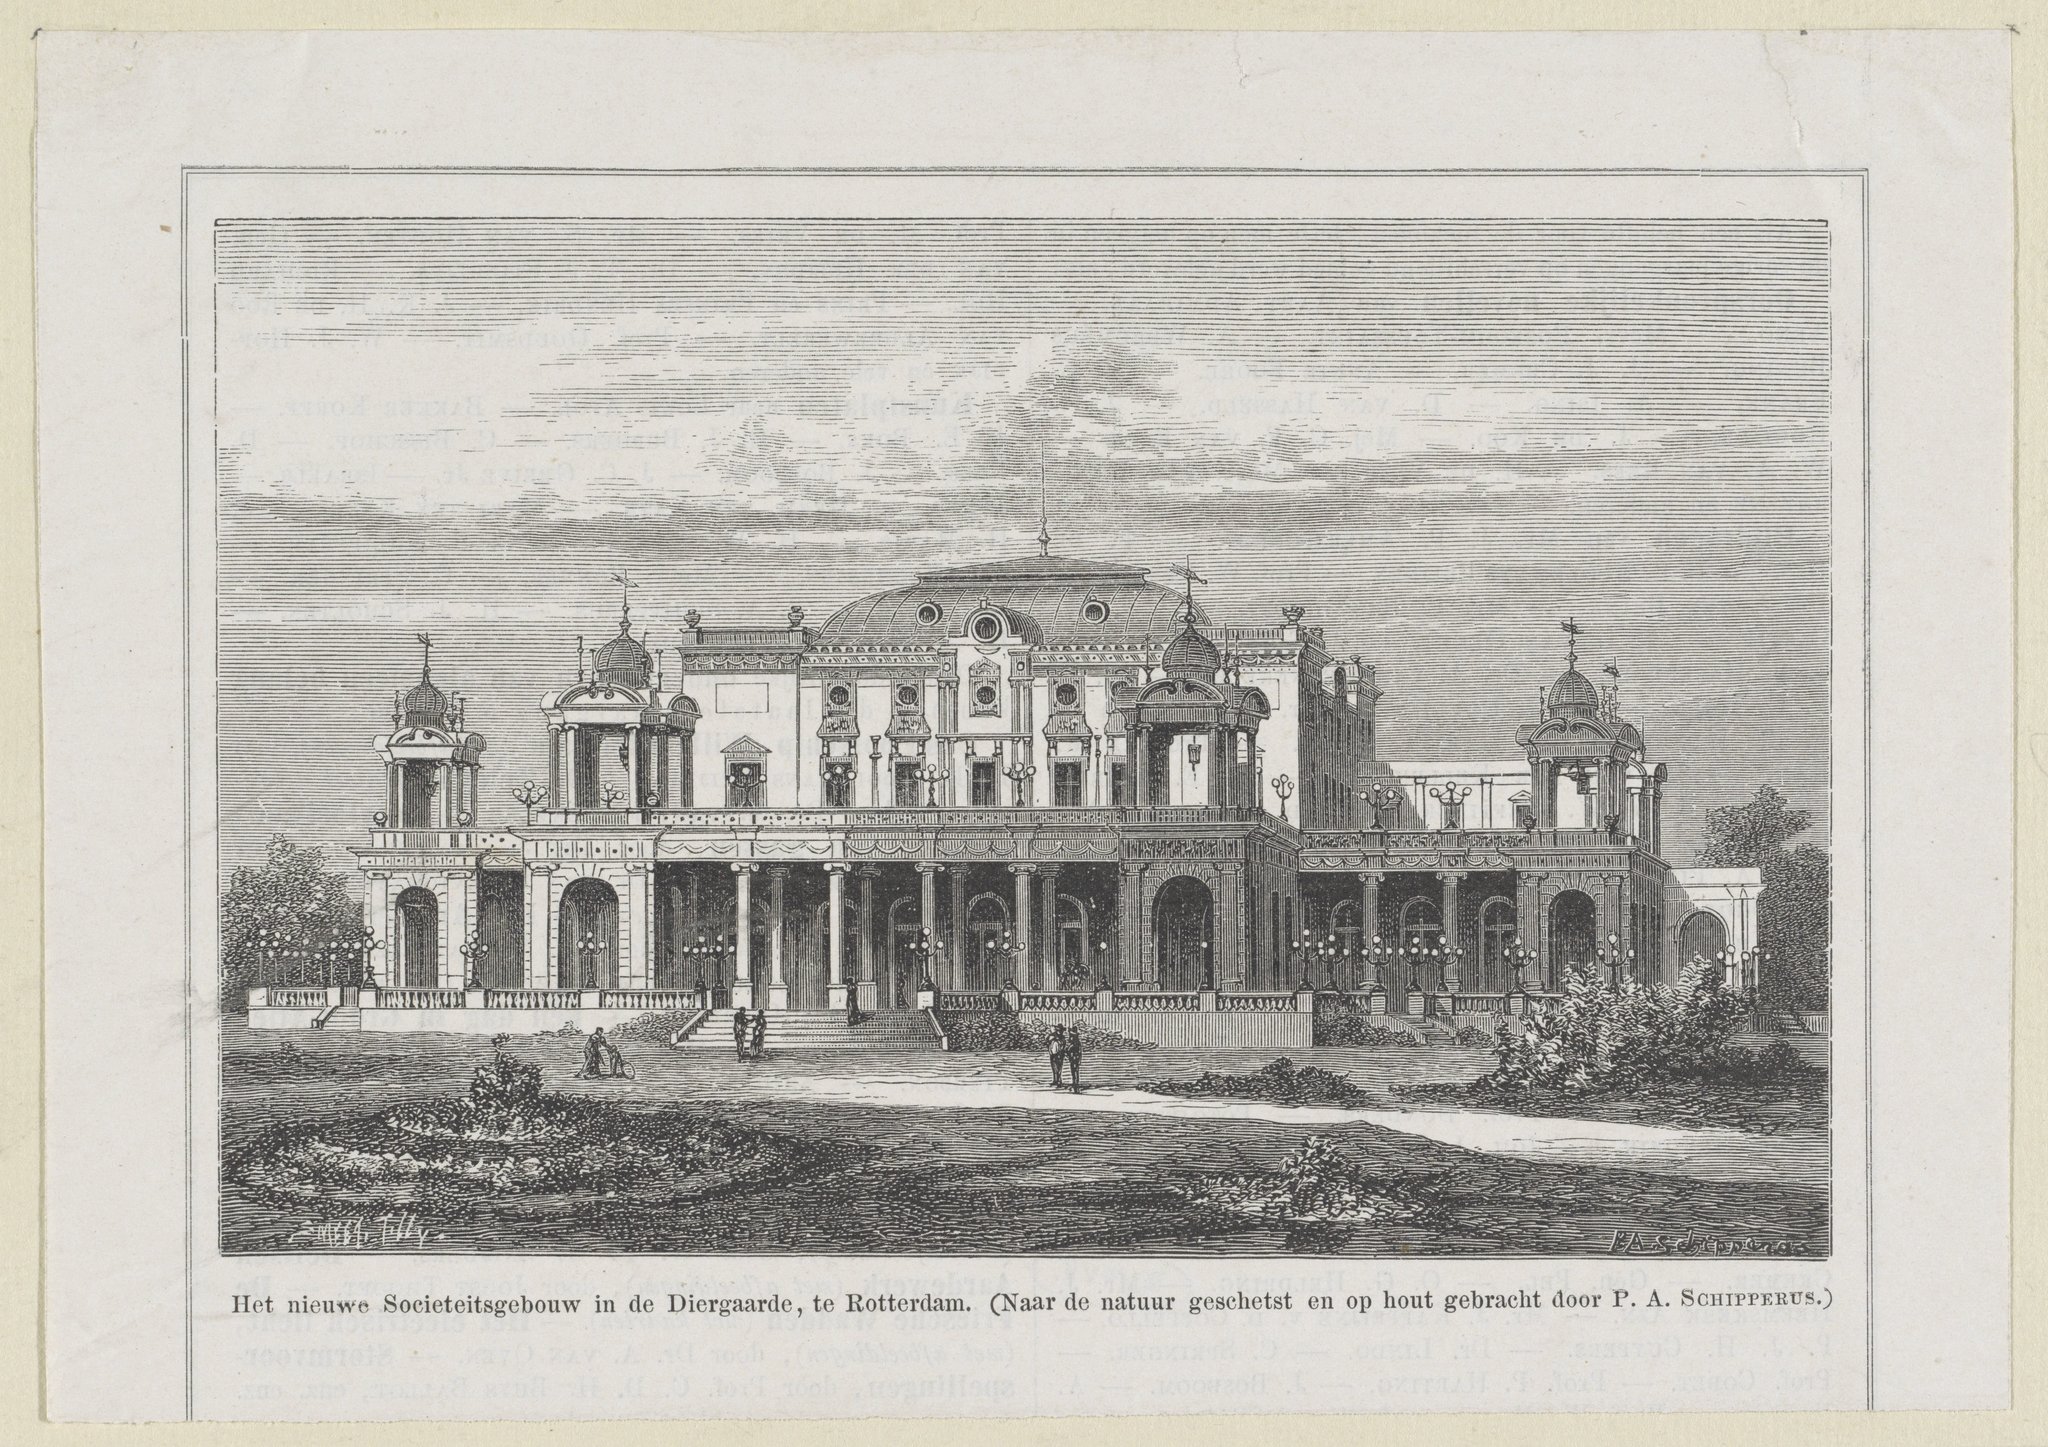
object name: book illustration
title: Het nieuwe societeitsgebouw in de Diergaarde, te Rotterdam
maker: piet schipperus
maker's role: draughtsman, print maker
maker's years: 1840-1929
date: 1874-1888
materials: paper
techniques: letterpress printing, engraving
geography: paris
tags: diergaarde blijdorp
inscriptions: collector's mark: Lugt 2228